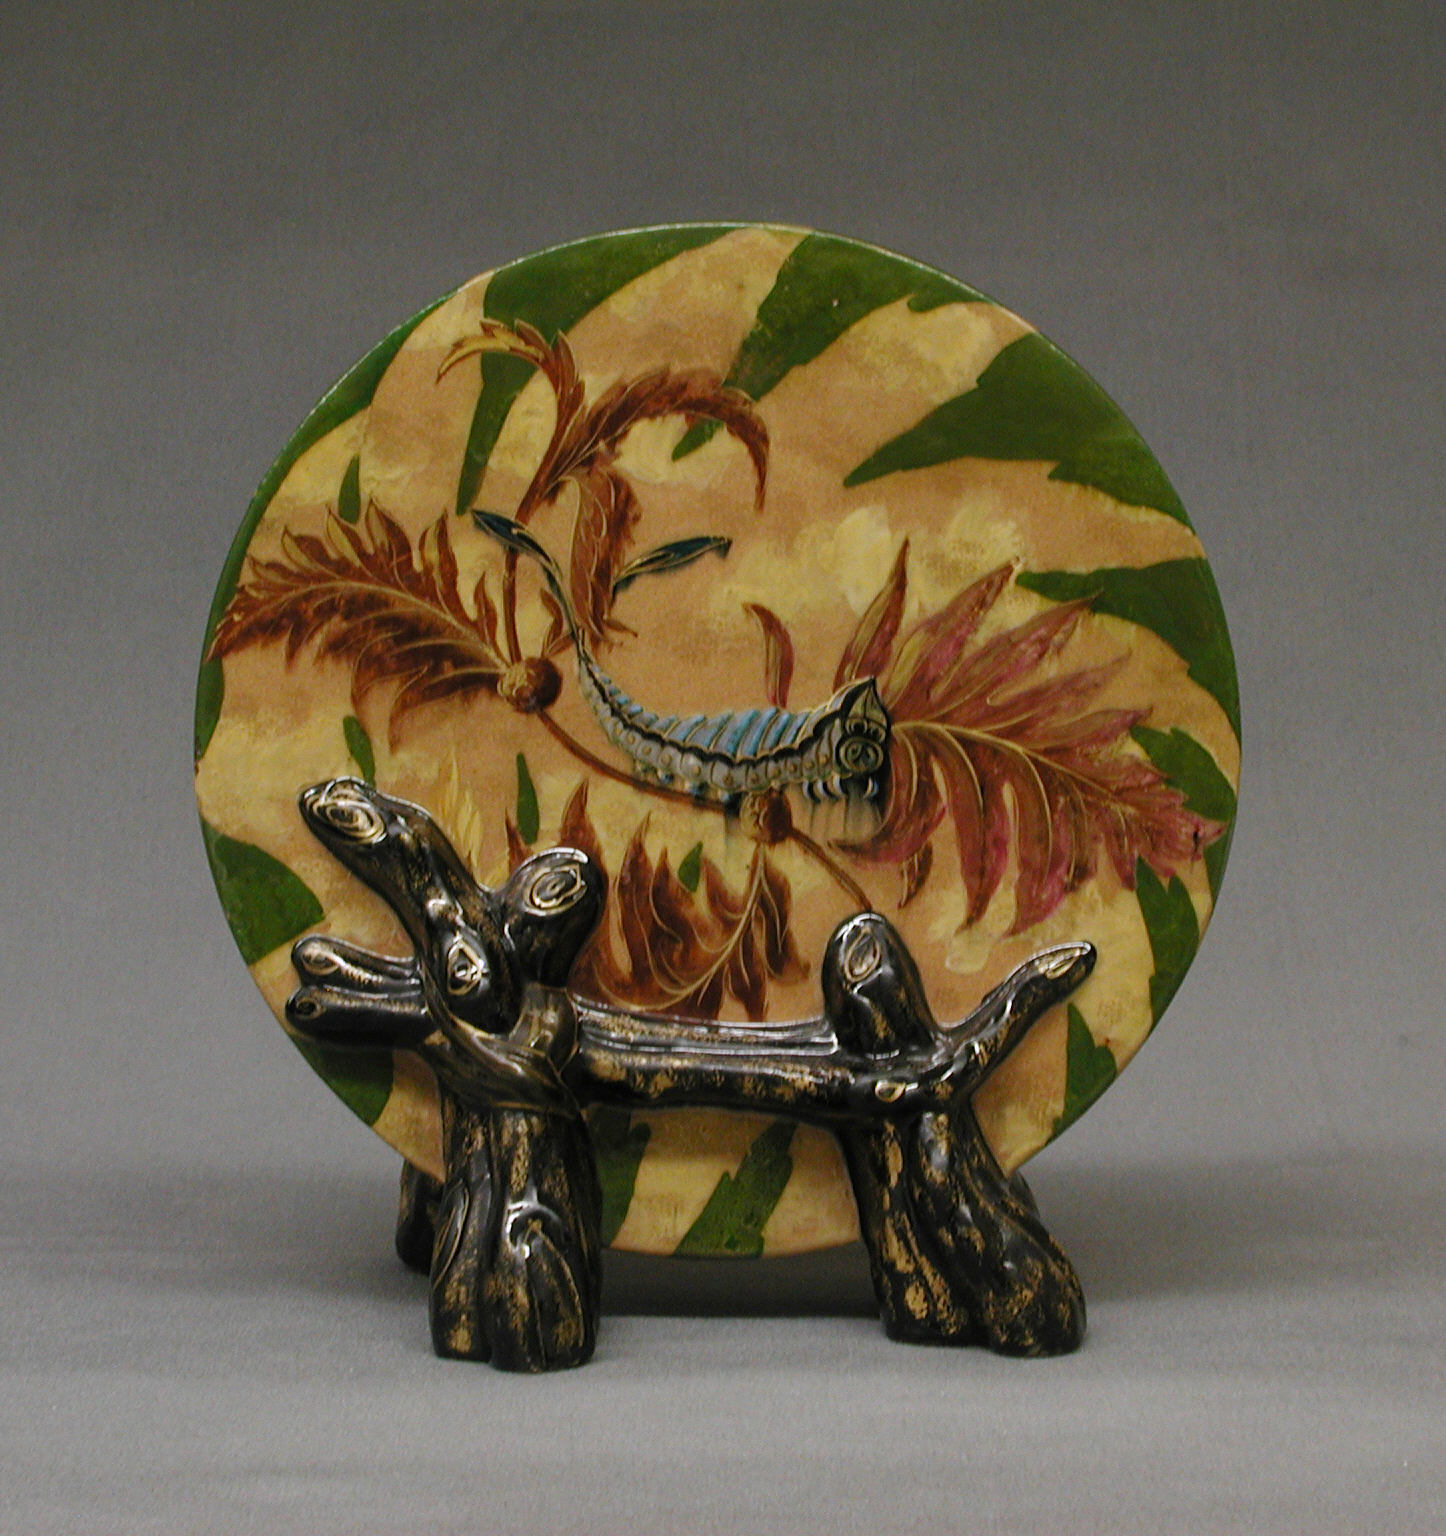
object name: vase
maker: emile gallé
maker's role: maker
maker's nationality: french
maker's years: 1846-1904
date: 1884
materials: earthenware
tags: insects